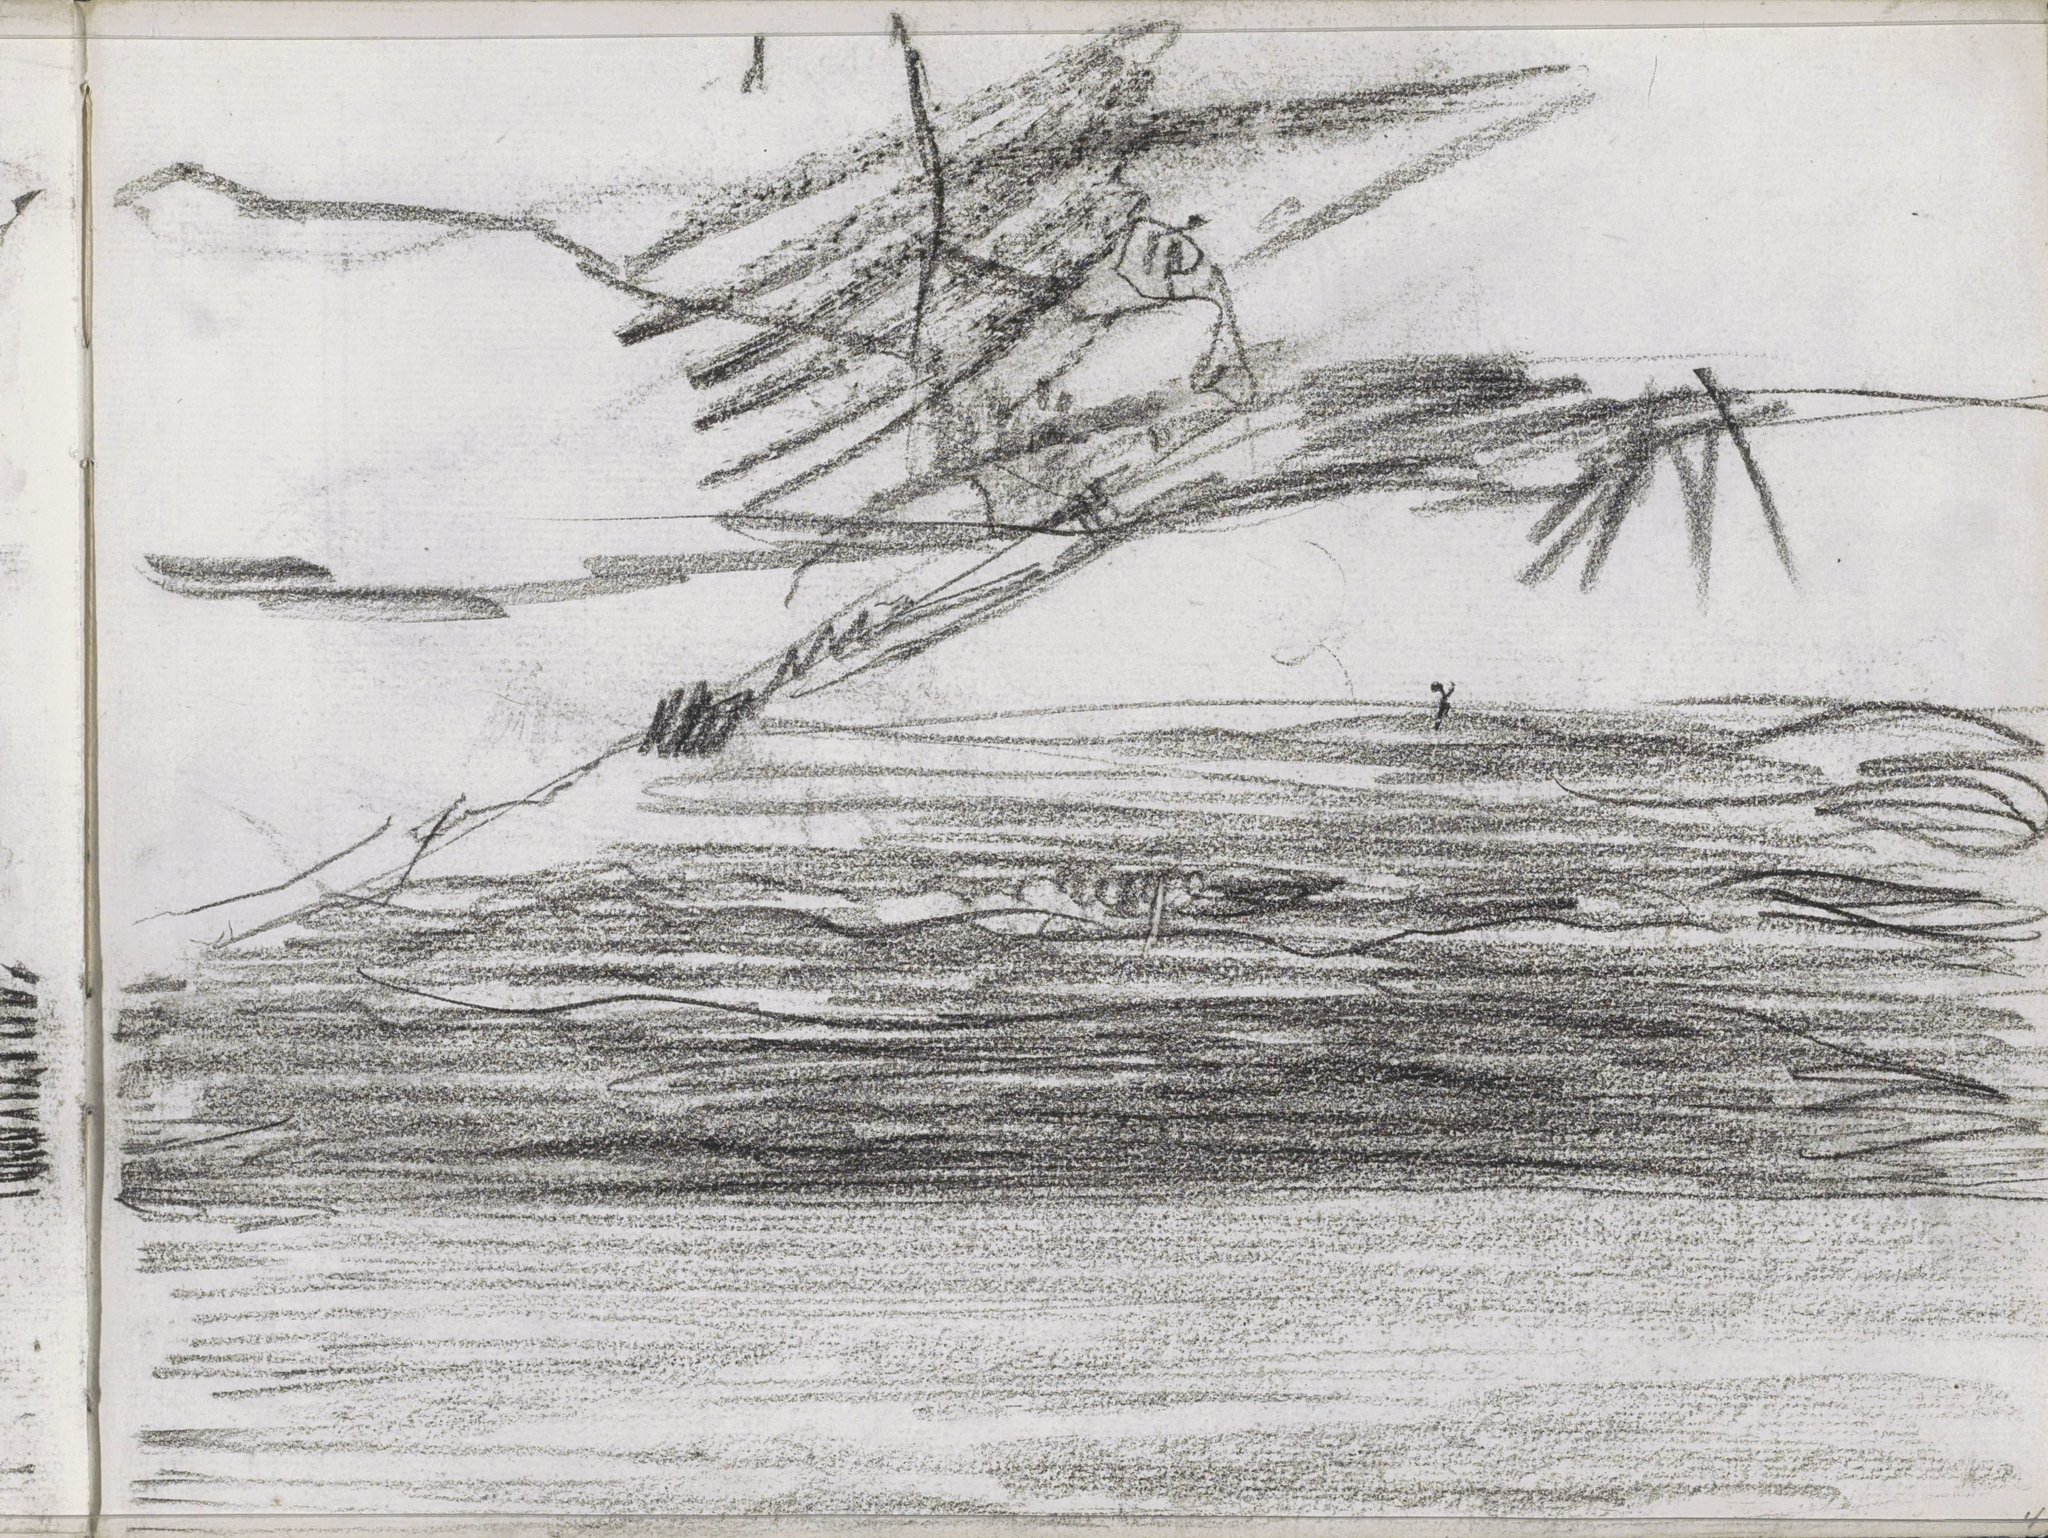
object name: sketchbook leaf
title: Kustgezicht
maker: isaac israels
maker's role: draughtsman, painter, print maker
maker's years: 1865-1934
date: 1875-1934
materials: chalk, paper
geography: the hague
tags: dune coast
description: Vooraan duinen. Bij de branding een figuur. Blad 4 recto uit schetsboek XIV met 17 bladen.